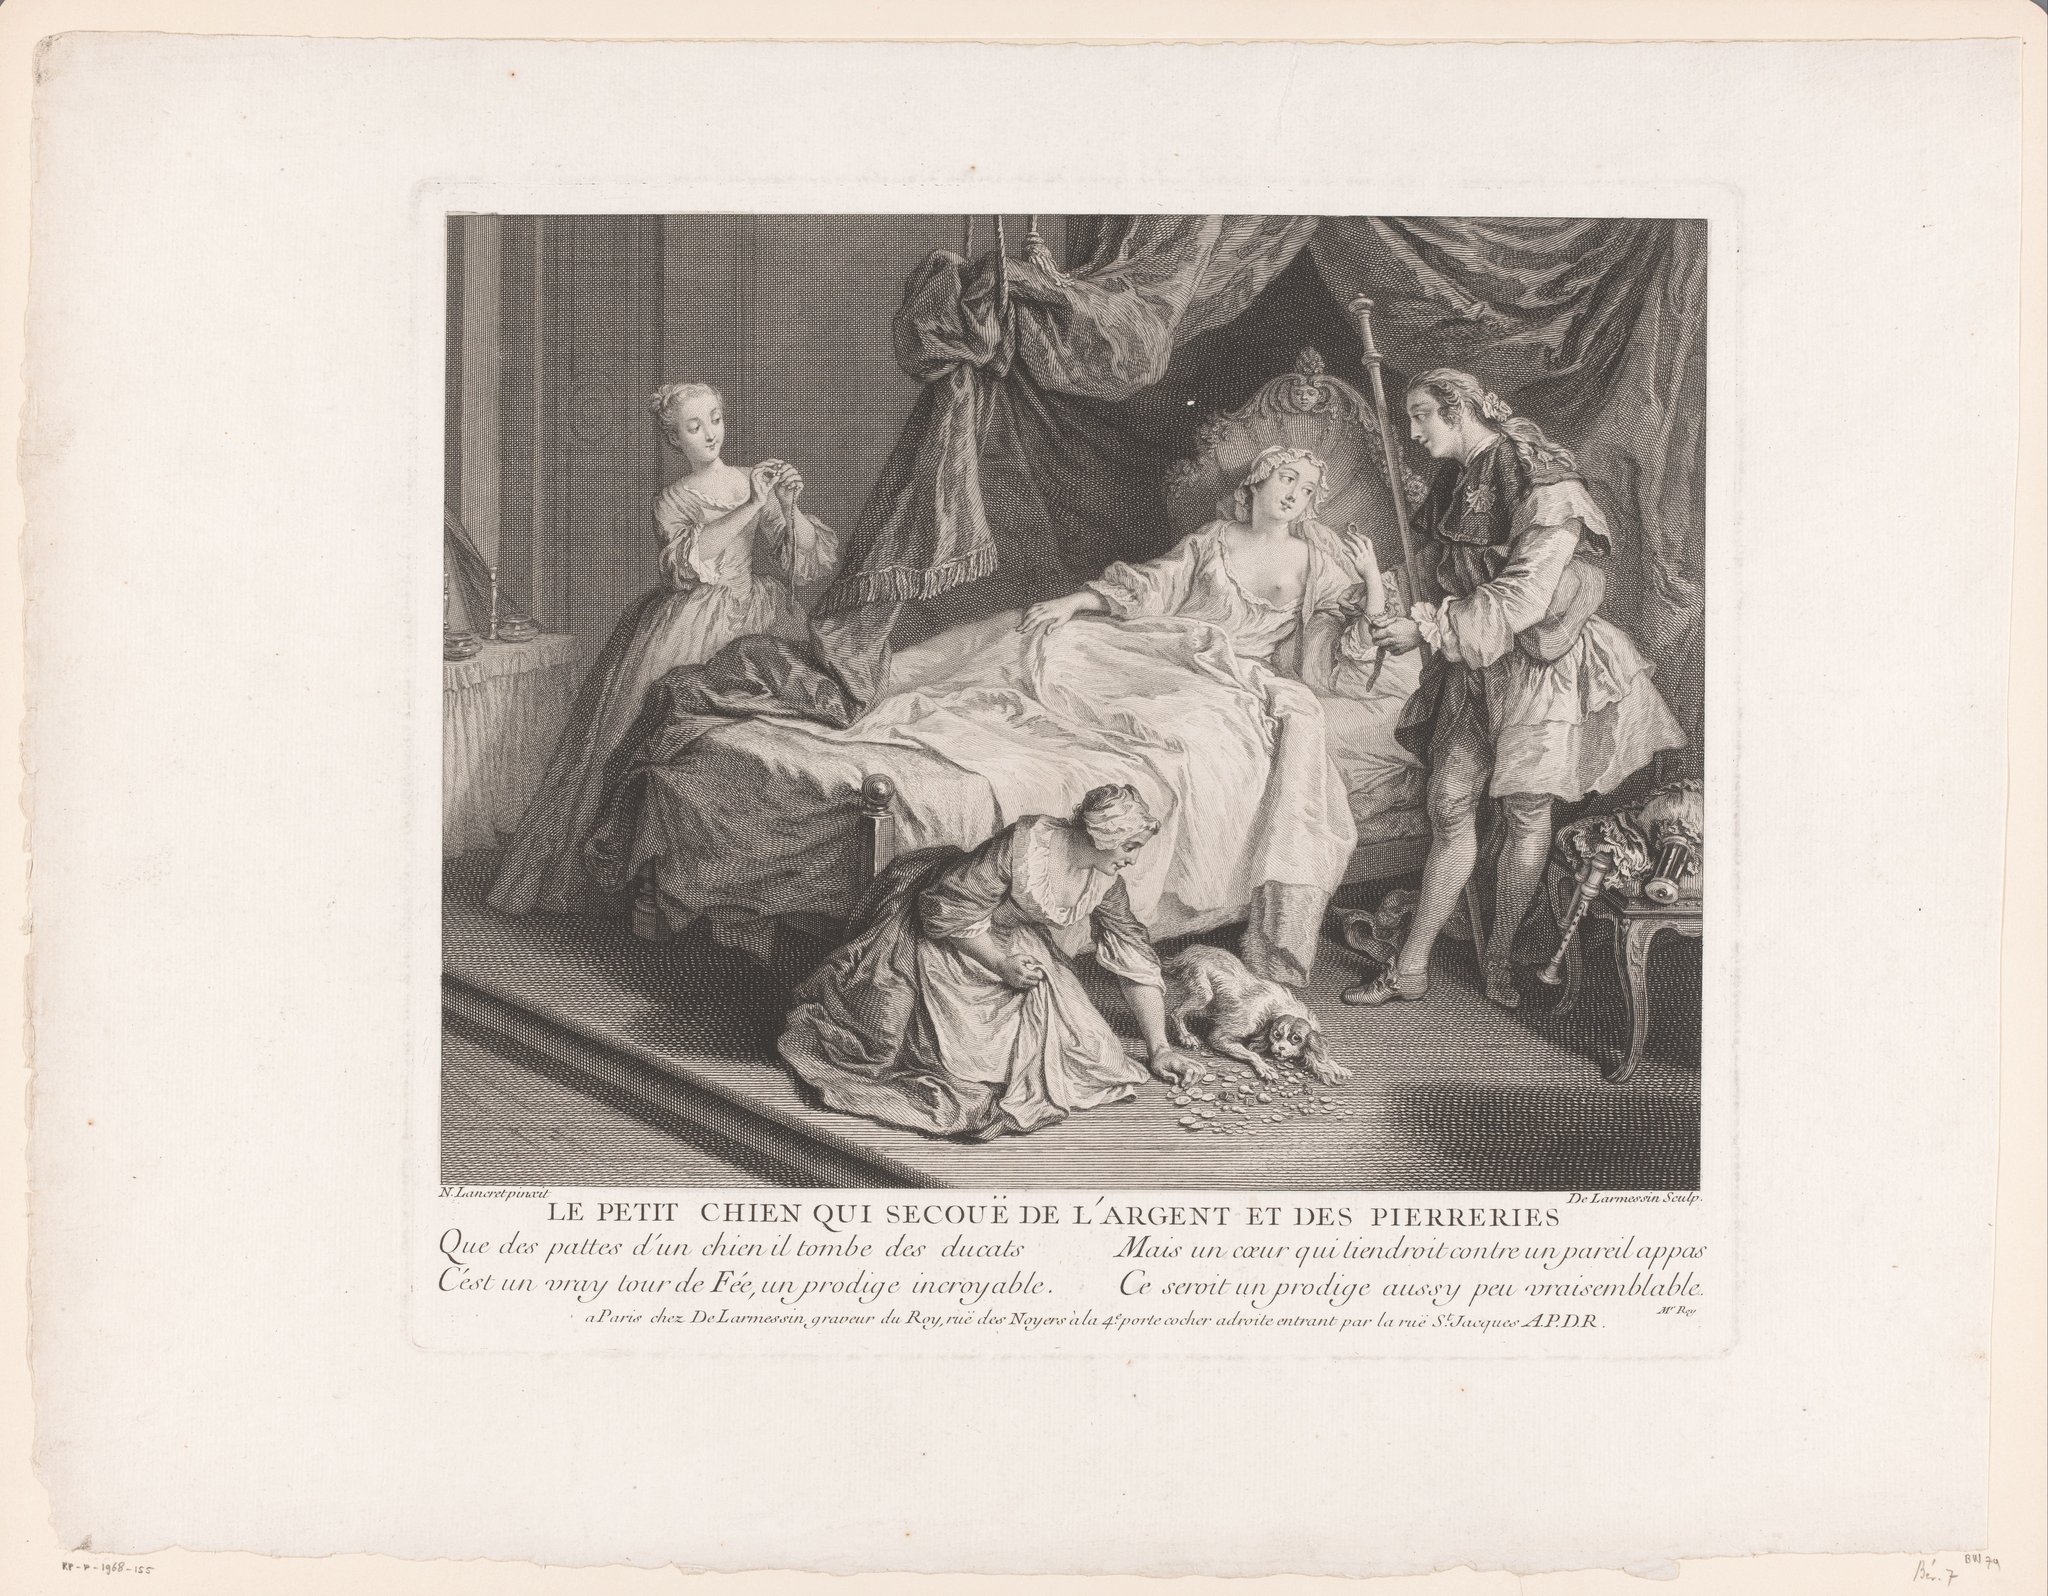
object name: print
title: Fabels van Jean de La Fontaine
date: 1736-1743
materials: paper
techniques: engraving, etching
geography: france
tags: putting on jewels, ornaments, jewels, lovers' meeting, bedroom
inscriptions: collector's mark: Lugt 2228, collector's mark: Lugt 2760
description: In een slaapkamer ligt een jonge vrouw met ontblote borst op bed. Naast haar staat een jongeman die de vrouw een armband omdoet. Naast het bed twee kamermeisjes en een hond. Op de voorgrond raapt het kamermeisje de munten en juwelen op de grond bij elkaar.